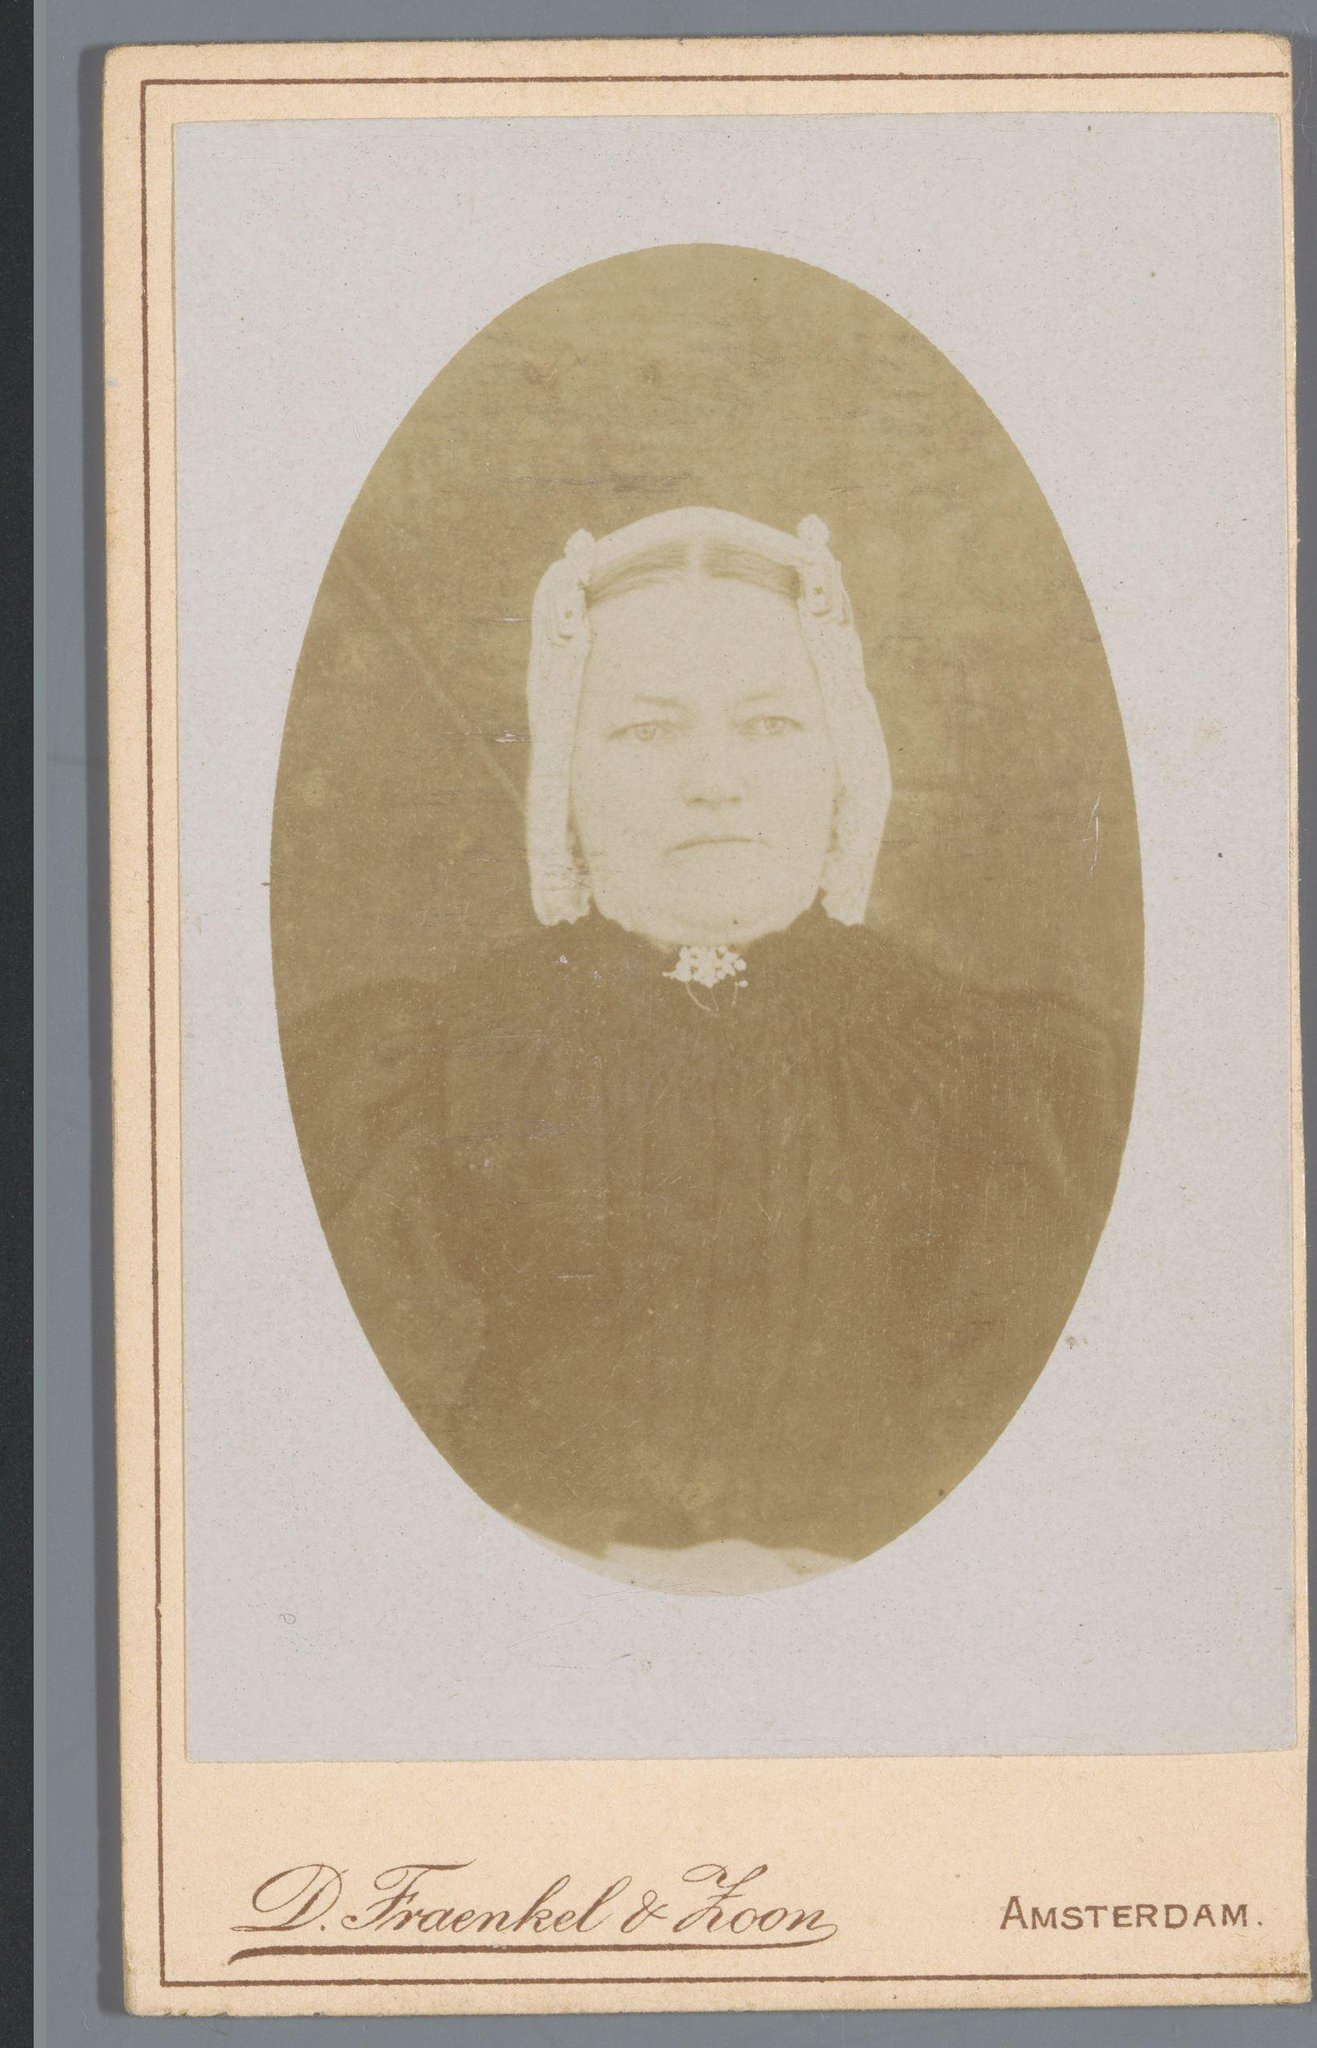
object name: photograph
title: Portret van Hiltje Middelbeek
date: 1890-1910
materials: cardboard, photographic support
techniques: gelatin silver print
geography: amsterdam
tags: historical persons - bb - woman, head-gear: cap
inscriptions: inscription: ‘D. Fraenkel & Zoon/ PHOTOGRAPHEN/ AMSTERDAM 43. Commelinstraat 43./ Specialiteit in vergrootingen van deze Portretten/ kunnen steeds nabesteld worden./ ALEX: LINDNER, BERLIN.’, inscription: ‘Hiltje Middelbeek’